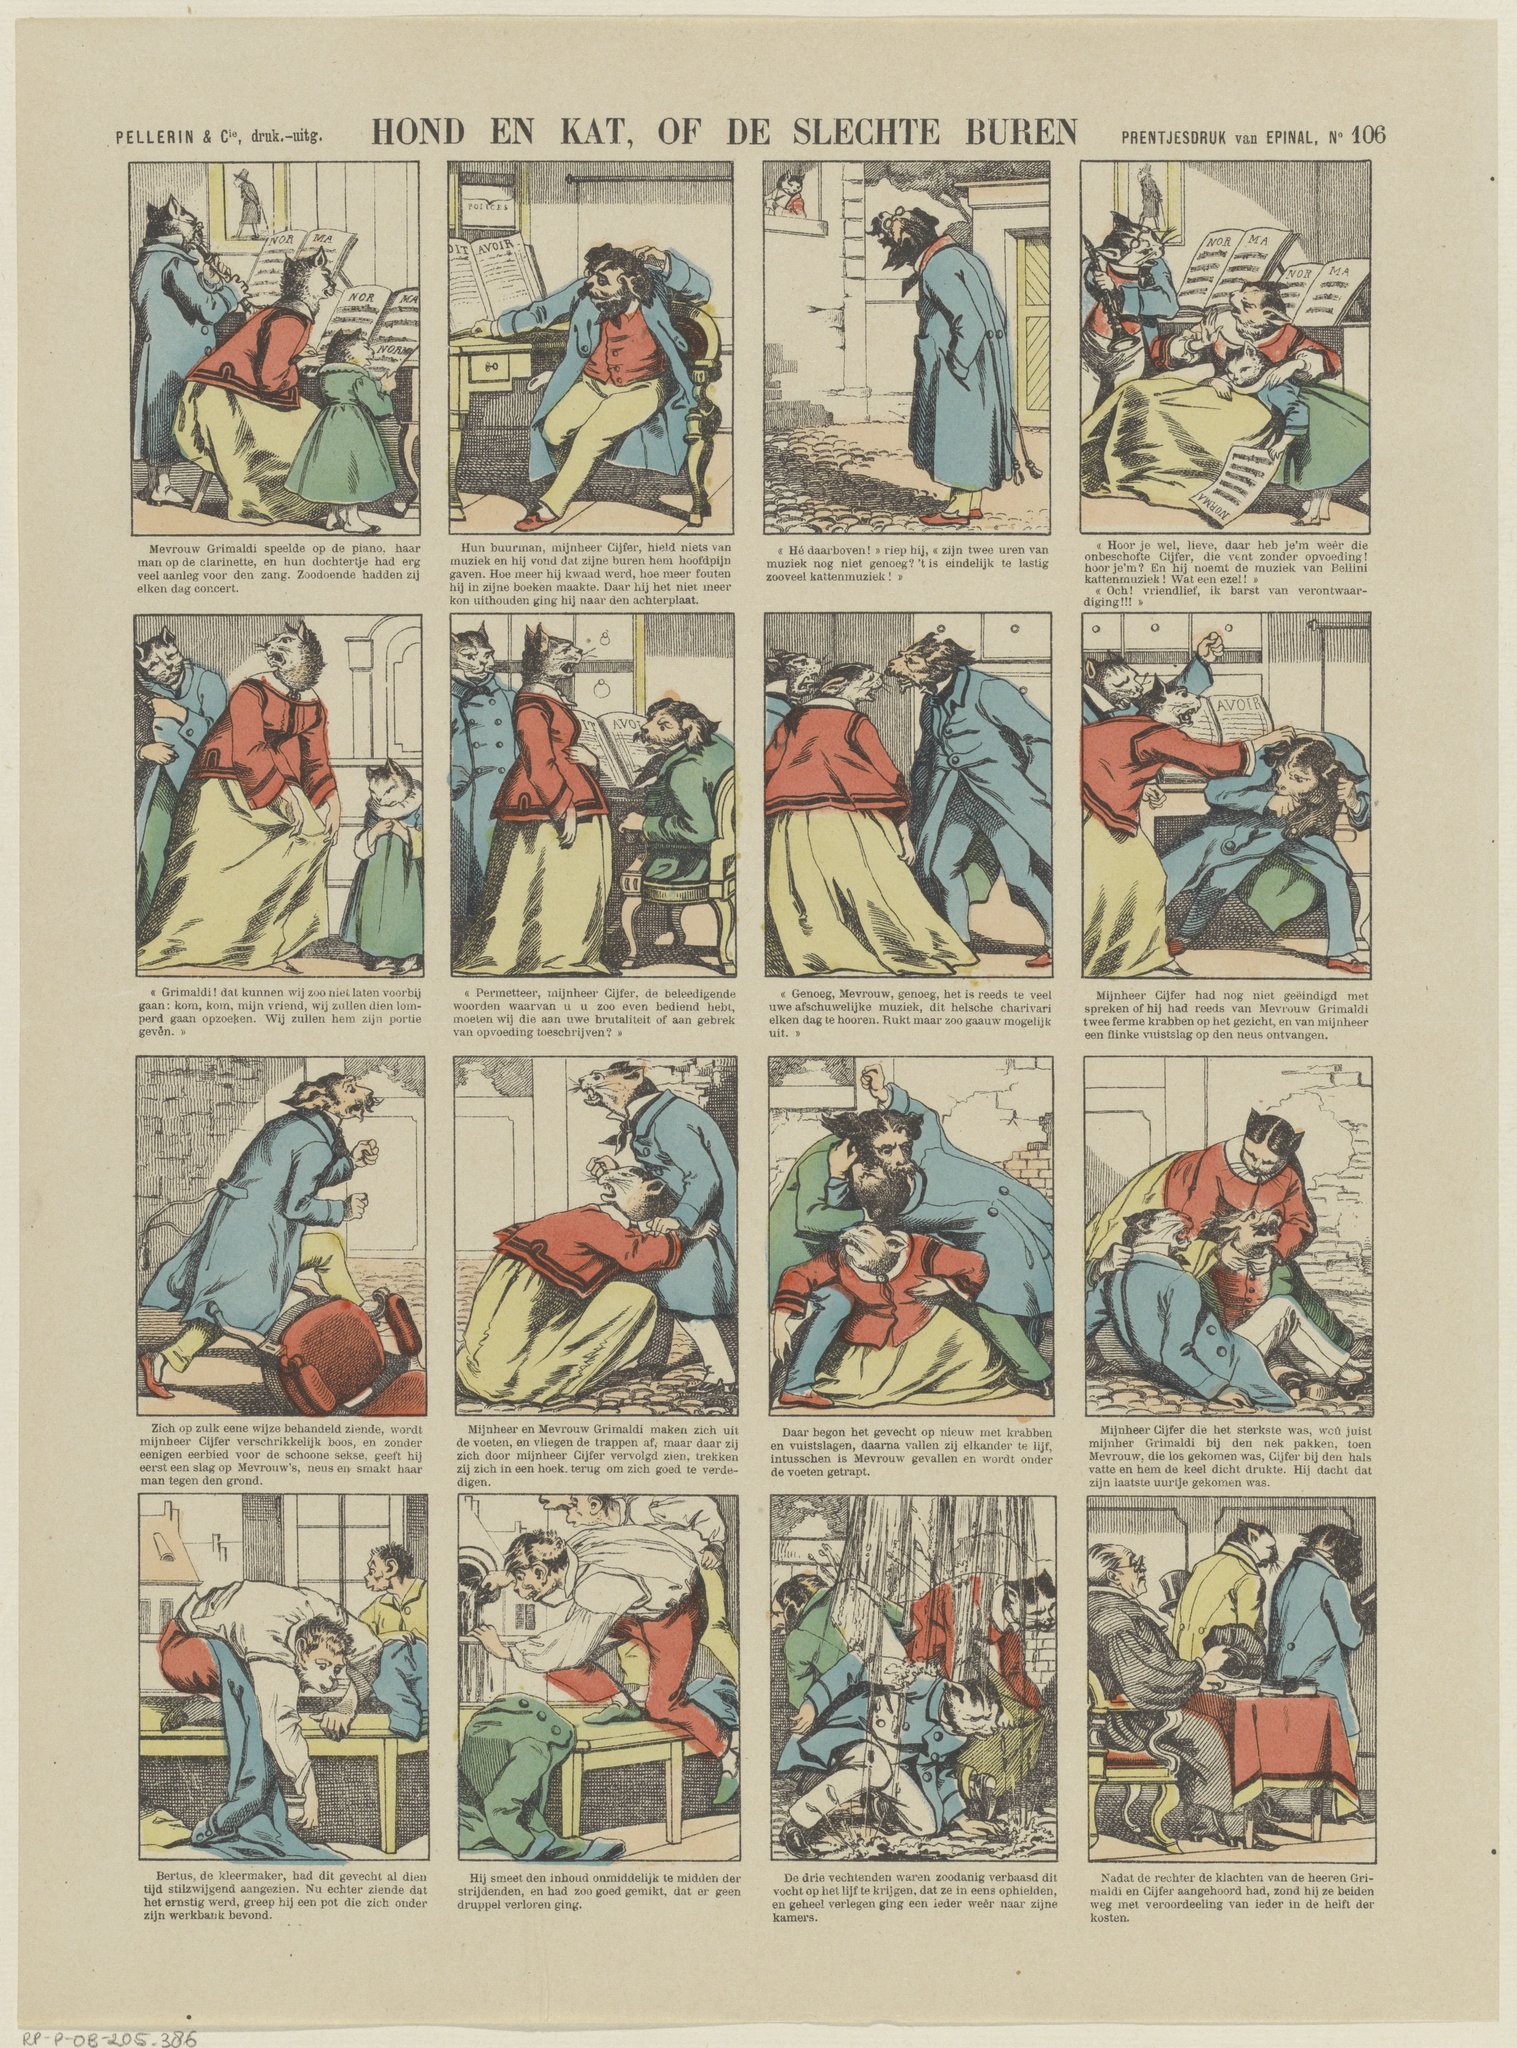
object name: popular print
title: Prentjesdruk van Epinal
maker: Anonymous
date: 1902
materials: paper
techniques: colour, letterpress printing, lithograph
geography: epinal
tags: cat, monkeys, apes, animals acting as human beings, quarrel, argument, dog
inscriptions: collector's mark: Lugt 2760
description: Blad met 20 voorstellingen over een burenruzie. Onder elke afbeelding een onderschrift. Genummerd rechtsboven: No 106.